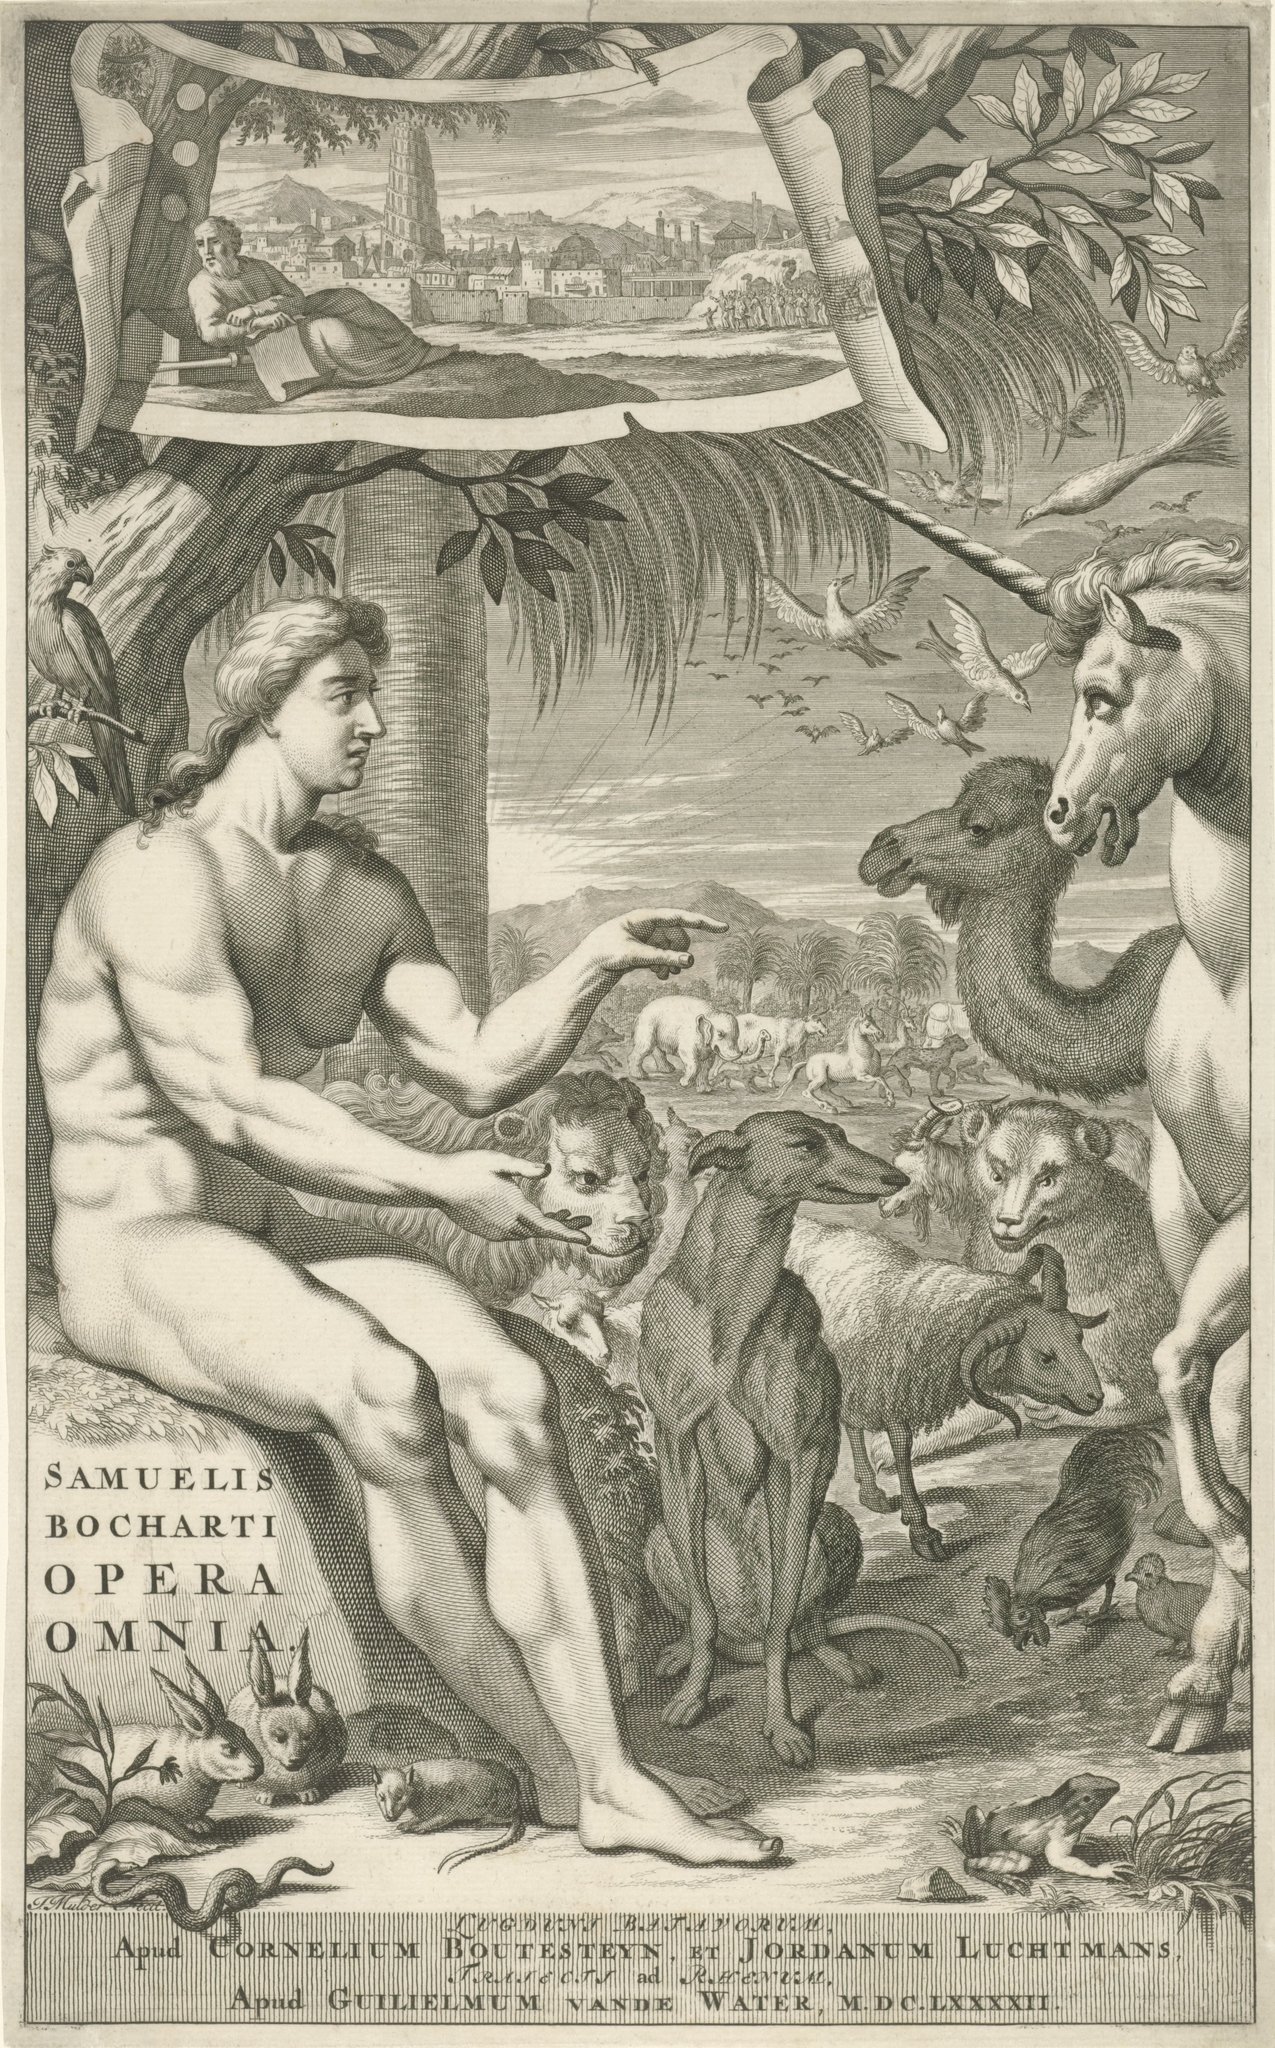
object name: print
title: Titelpagina voor: S. Bochart, Opera Omnia, 1692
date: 1692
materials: paper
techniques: engraving, etching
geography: utrecht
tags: adam naming the animals, the tower of babel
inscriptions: collector's mark: Lugt 2228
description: Adam, gezeten onder een boom, geeft de dieren hun namen. Op de inzet bovenaan een stad met een toren, vermoedelijk Babel, met op de voorgrond een man onder een boom. Titelpagina voor de verzamelde werken van theoloog en taalkundige Samuel Bochart.